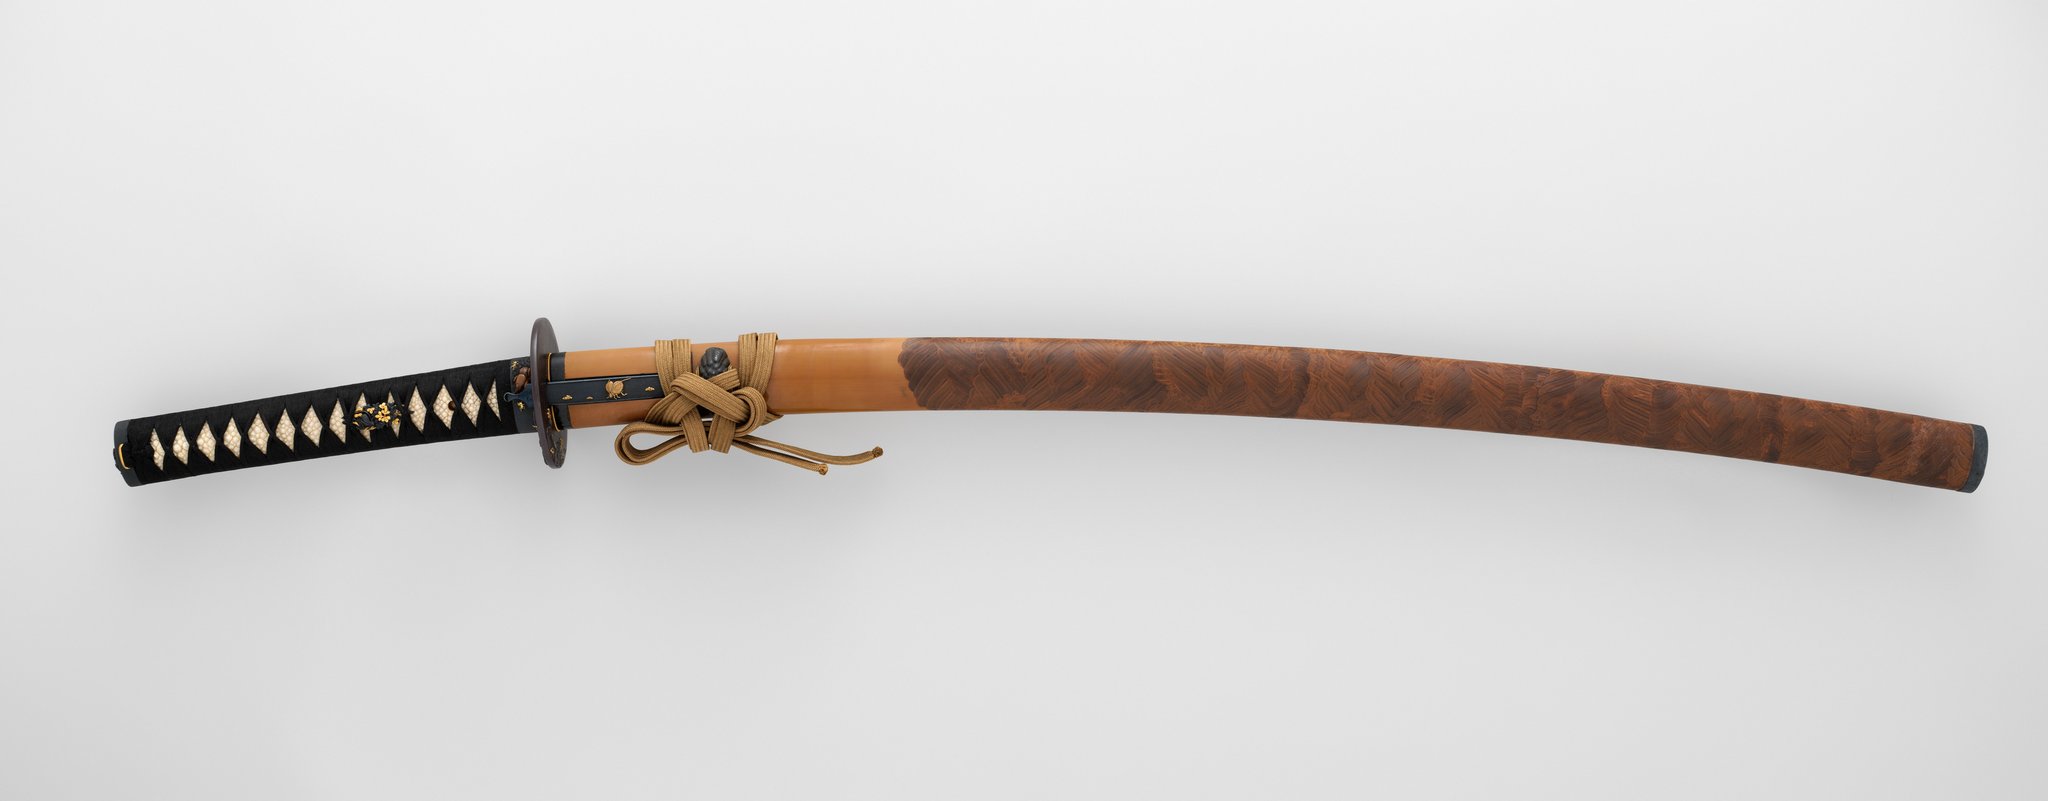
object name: blade and mounting for a pair of sword daishō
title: Blades and Mountings for a Pair of Swords (Daishō)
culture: japanese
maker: yokoyama kōzukedaijō sukesada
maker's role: swordsmith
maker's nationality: japanese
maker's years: 1627-1716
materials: gold alloy, silver alloy, gold, lacquer, silk, skin, steel, wood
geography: japan